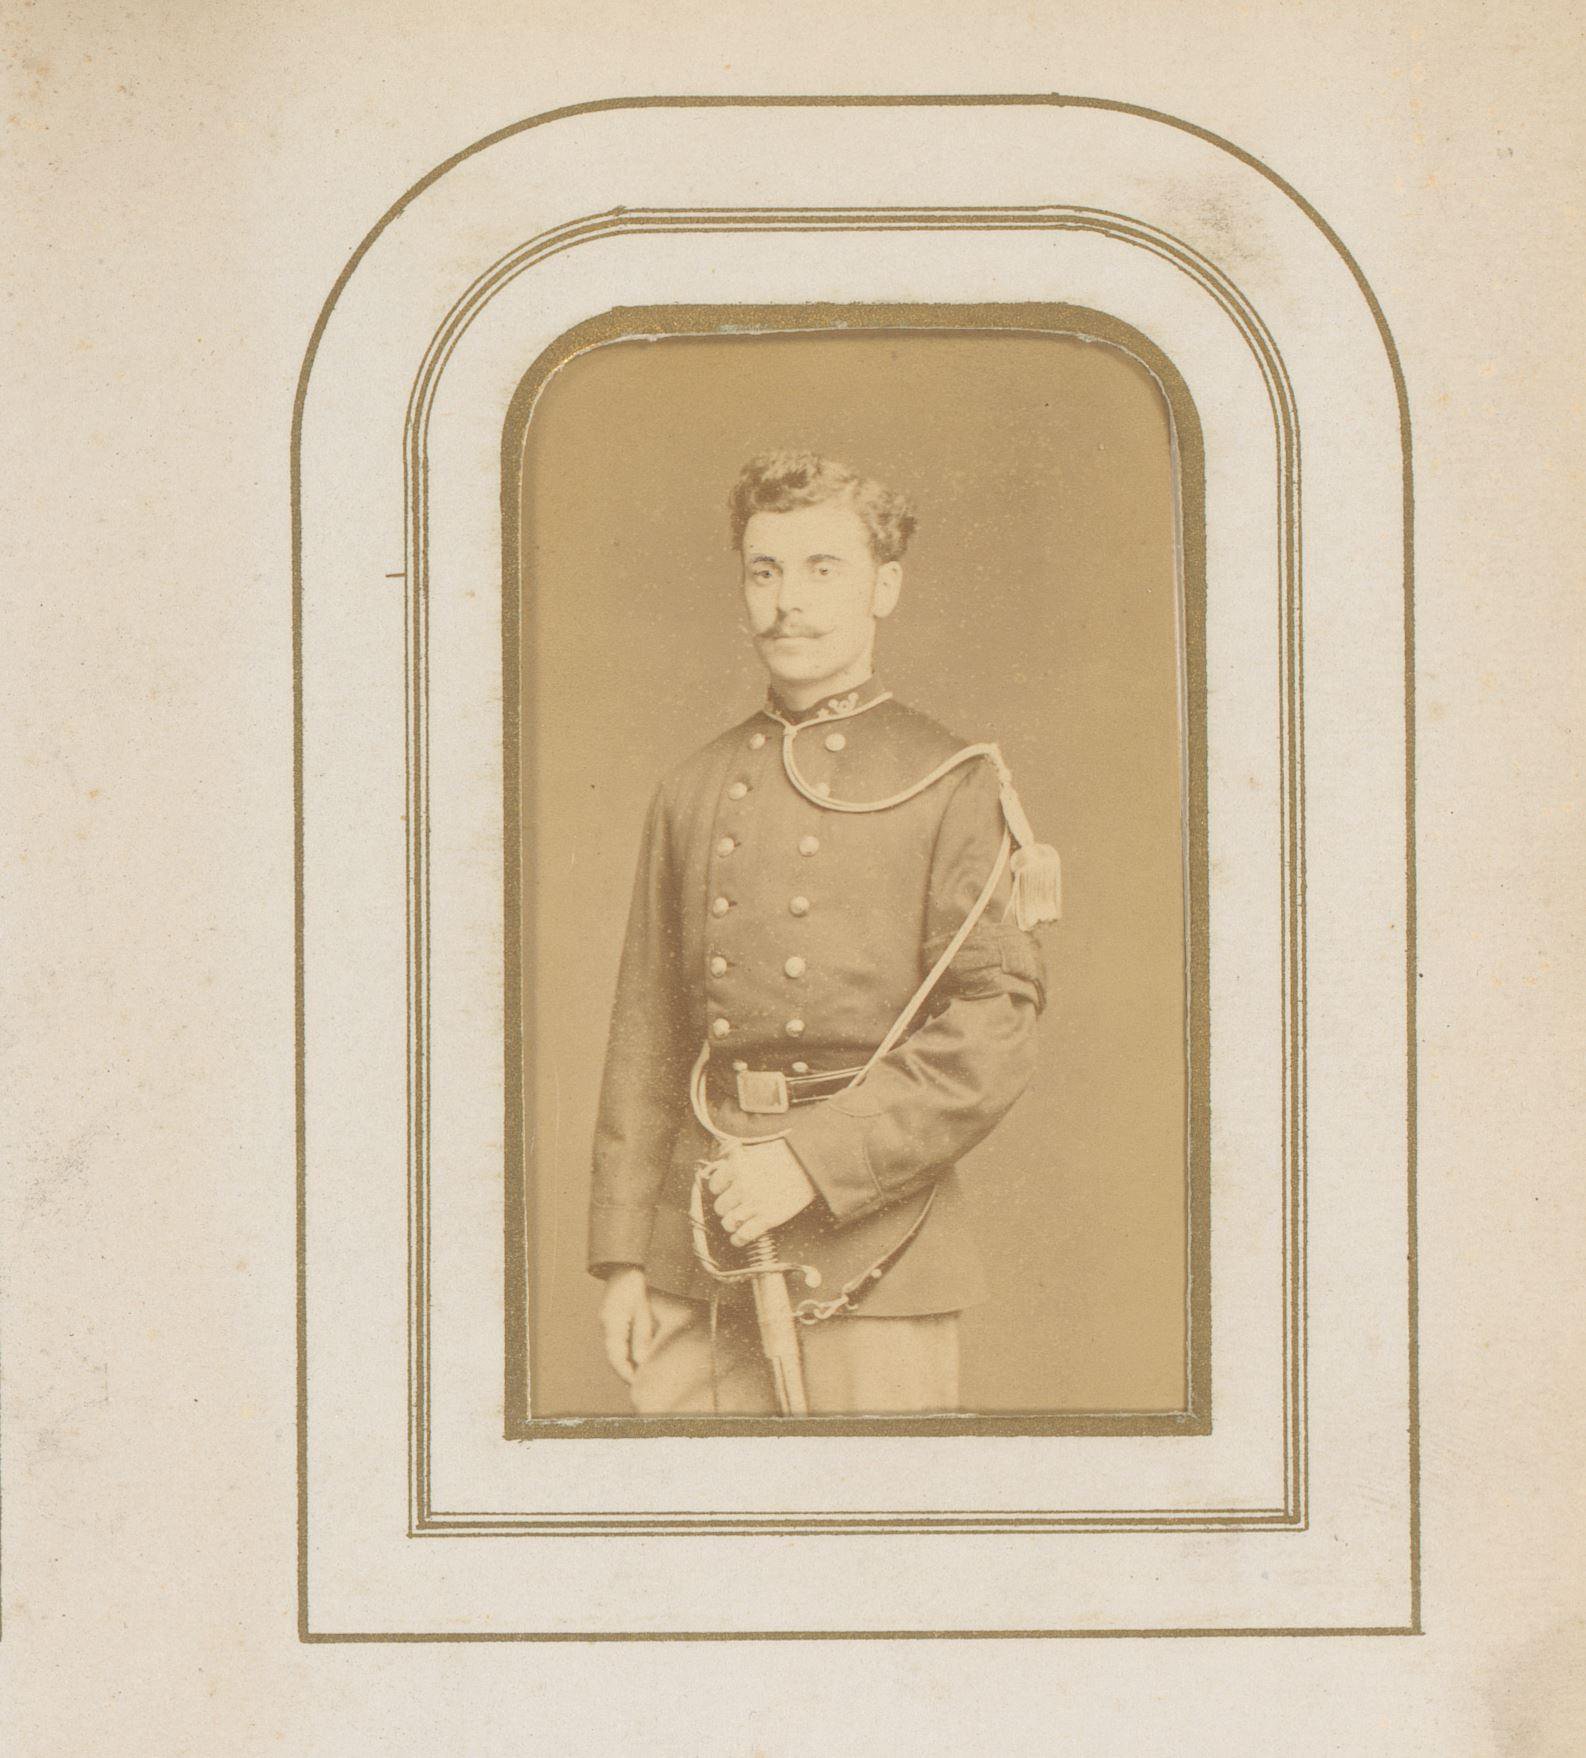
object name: carte de visite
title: Portret van een staande man met snor en zwaard in uniform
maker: albert delabarre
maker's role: musician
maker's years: 1809-1885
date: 1866-1884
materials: cardboard, photographic support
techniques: albumen print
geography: brussels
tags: moustache, historical persons, hacking and thrusting weapons: sword, (military) uniforms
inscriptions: inscription: ‘Photographie Parisienne/ 36, Rue Fossé aux Loups, 36/ (Place de la Monnaie)/ Bruxelles’, number: ‘10’